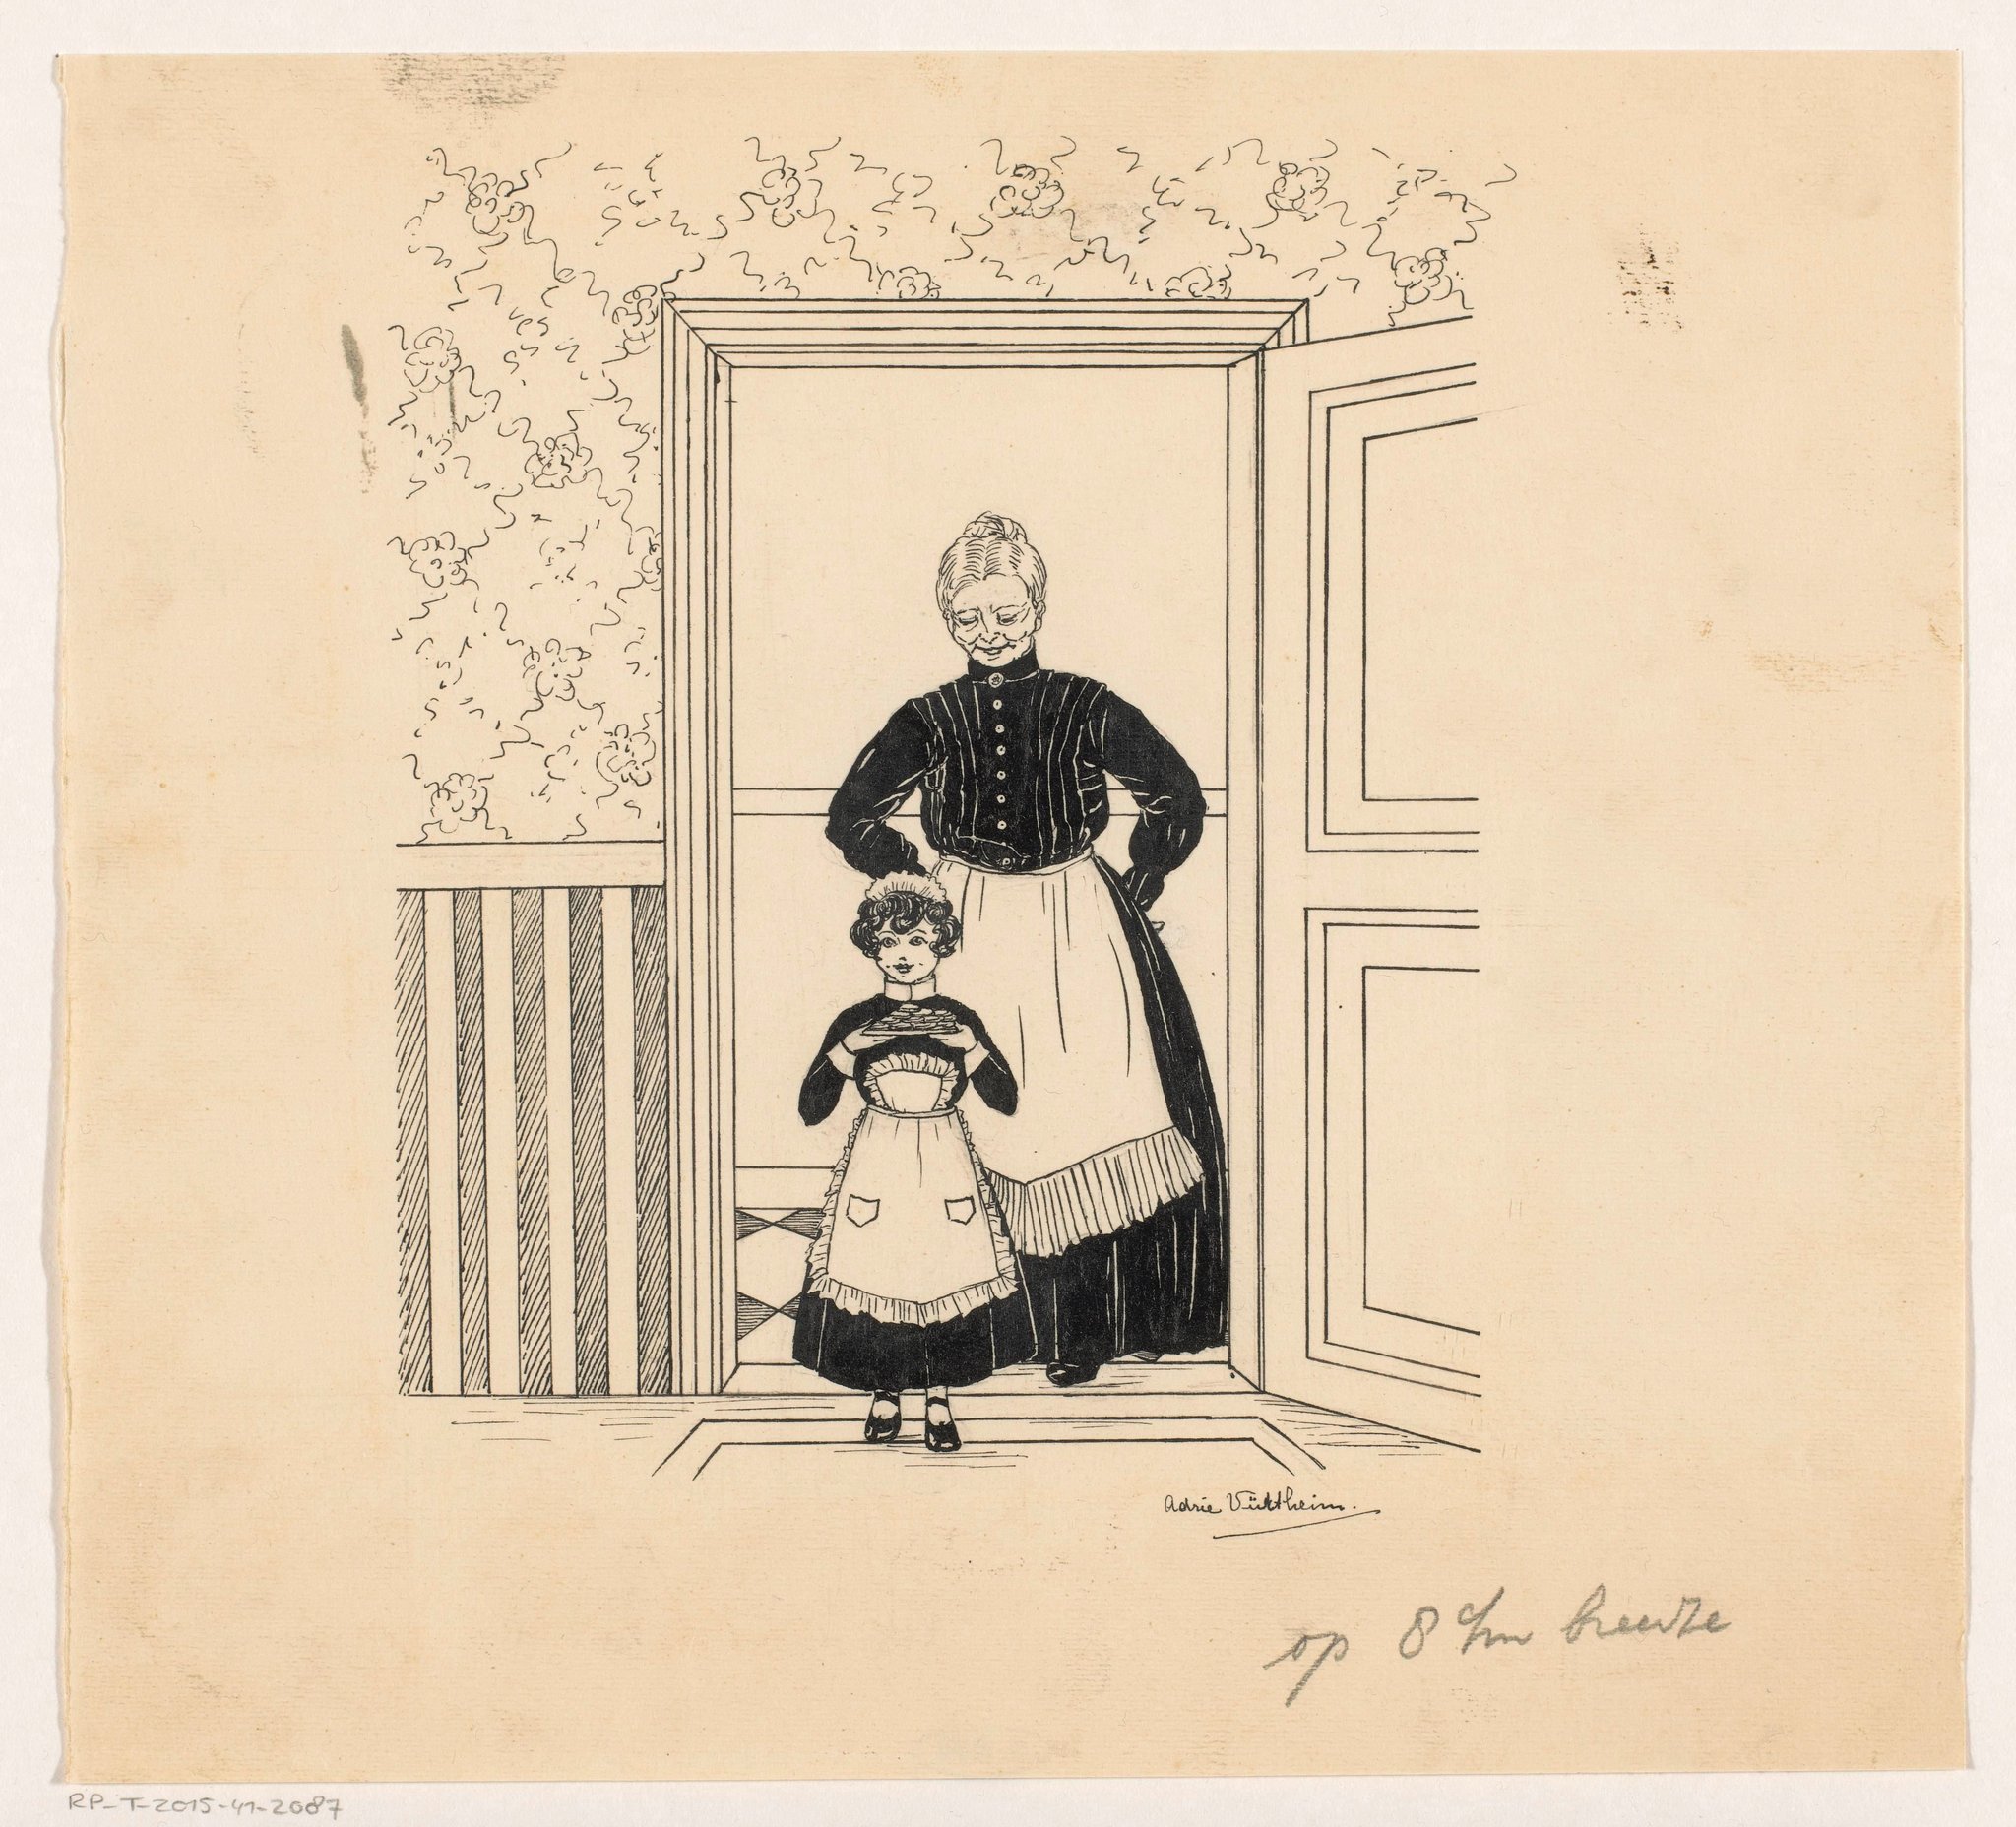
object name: boekillustratie ontwerp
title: Dienstmeisje met een schaal met koek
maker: adrie vürtheim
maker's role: draughtsman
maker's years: 1907-1995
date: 1917-1970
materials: ink, paper, pencil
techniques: brush, pen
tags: open door, bread, cake, pastry, etc., maid ~ house personnel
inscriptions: signature: ‘Adrie Vürtheim.’, collector's mark: Lugt 2228a, :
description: Een oude vrouw en een meisje, beiden gekleed in het uniform van een dienstmeid, staan in een deuropening. Het meisje houdt met beide handen een schaal met koek vast. De oudere vrouw kijkt toe.